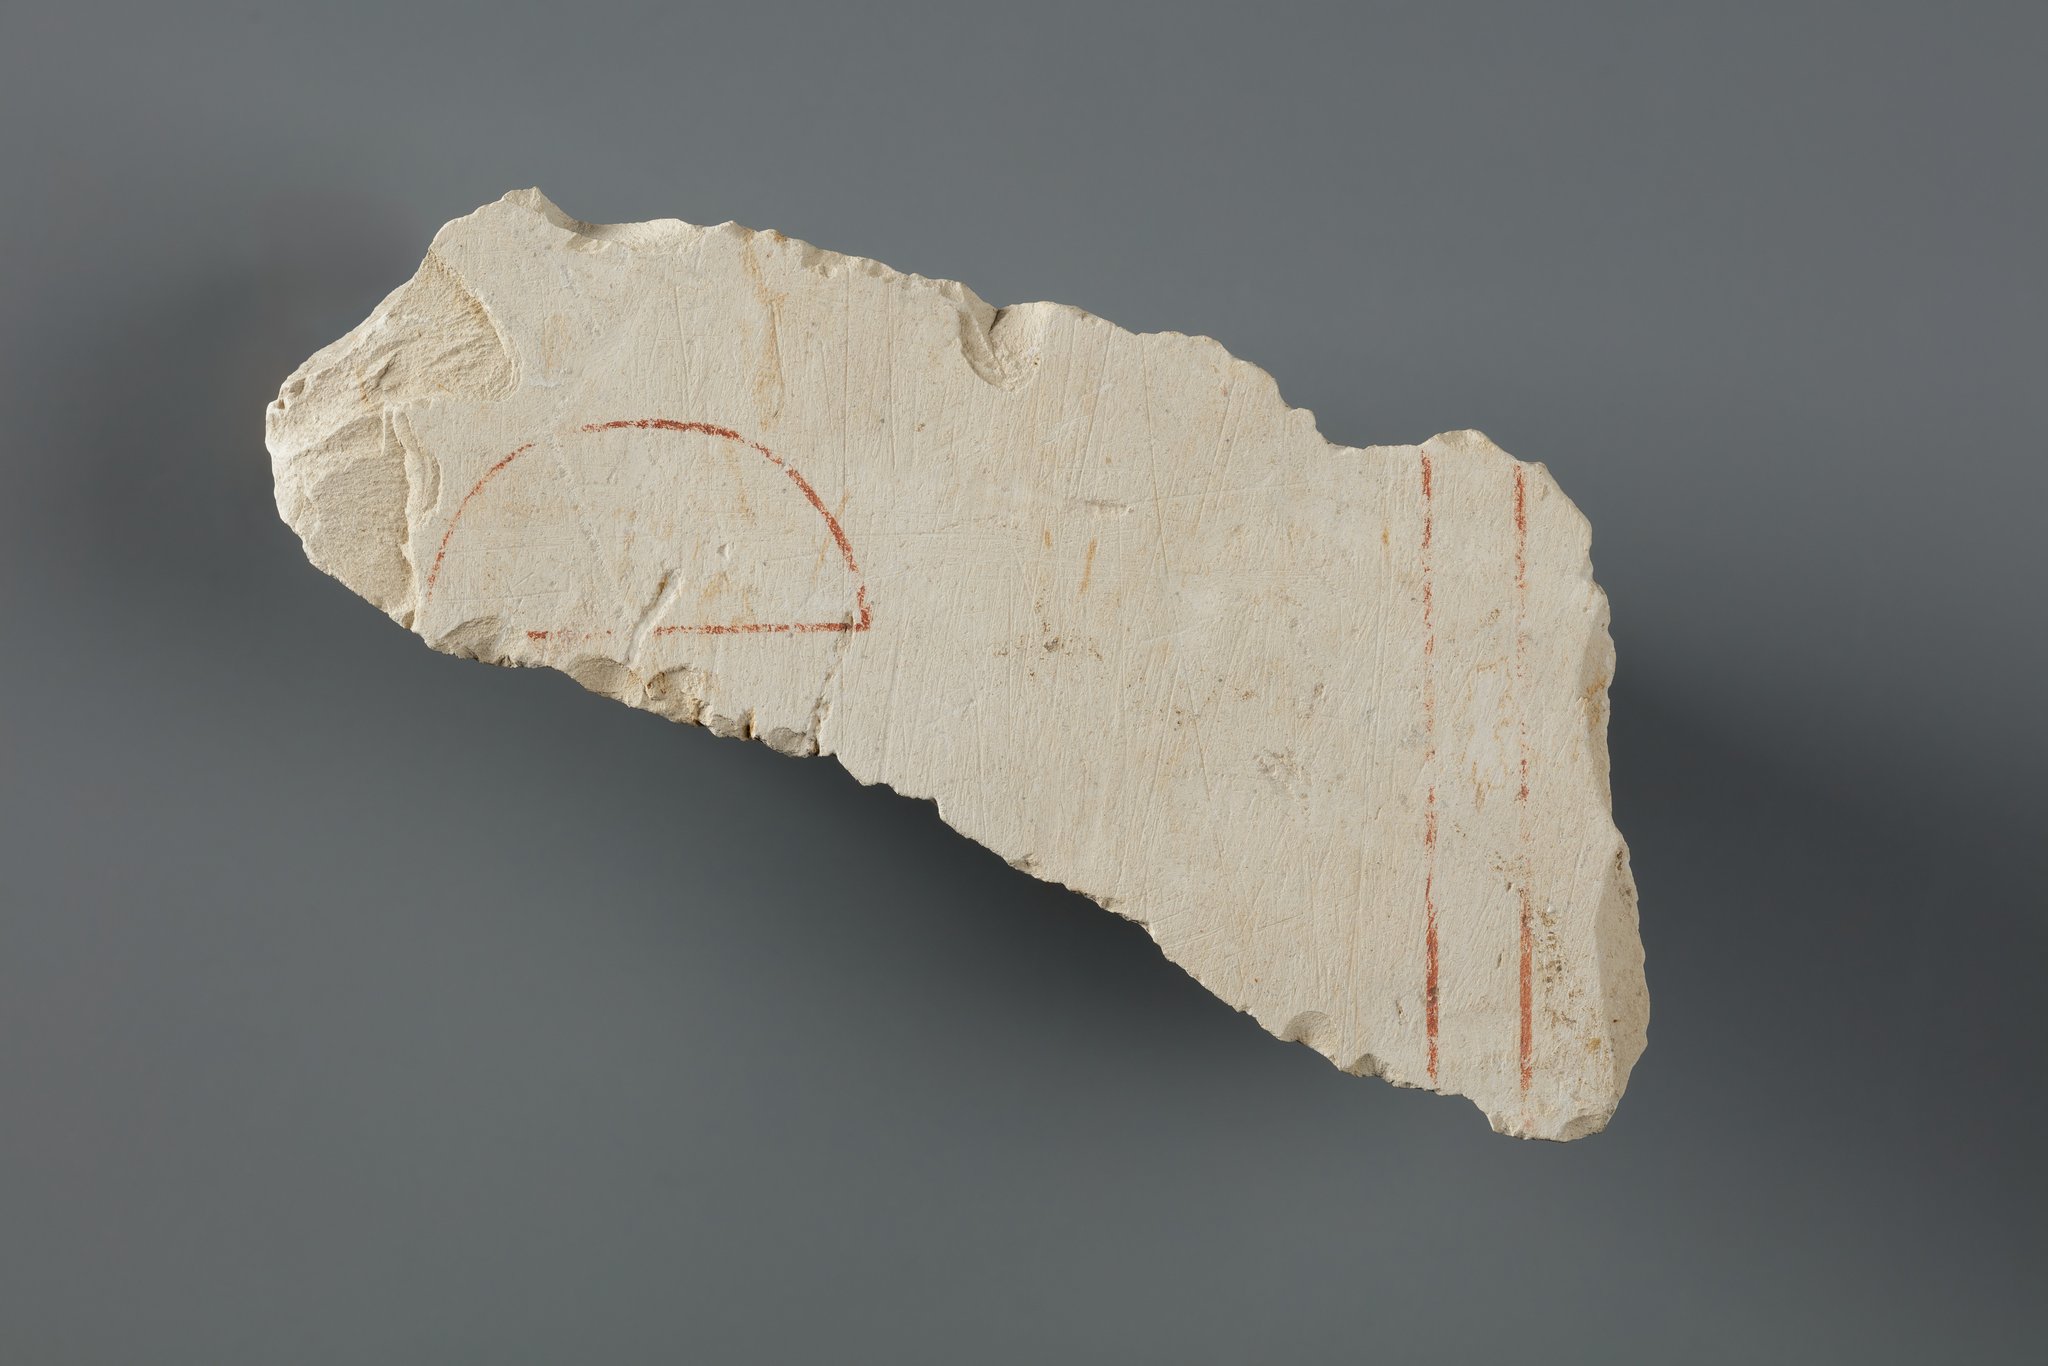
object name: relief drawing, sebeknakhte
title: Preliminary drawing for a relief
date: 2124-1504 BCE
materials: limestone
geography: egypt